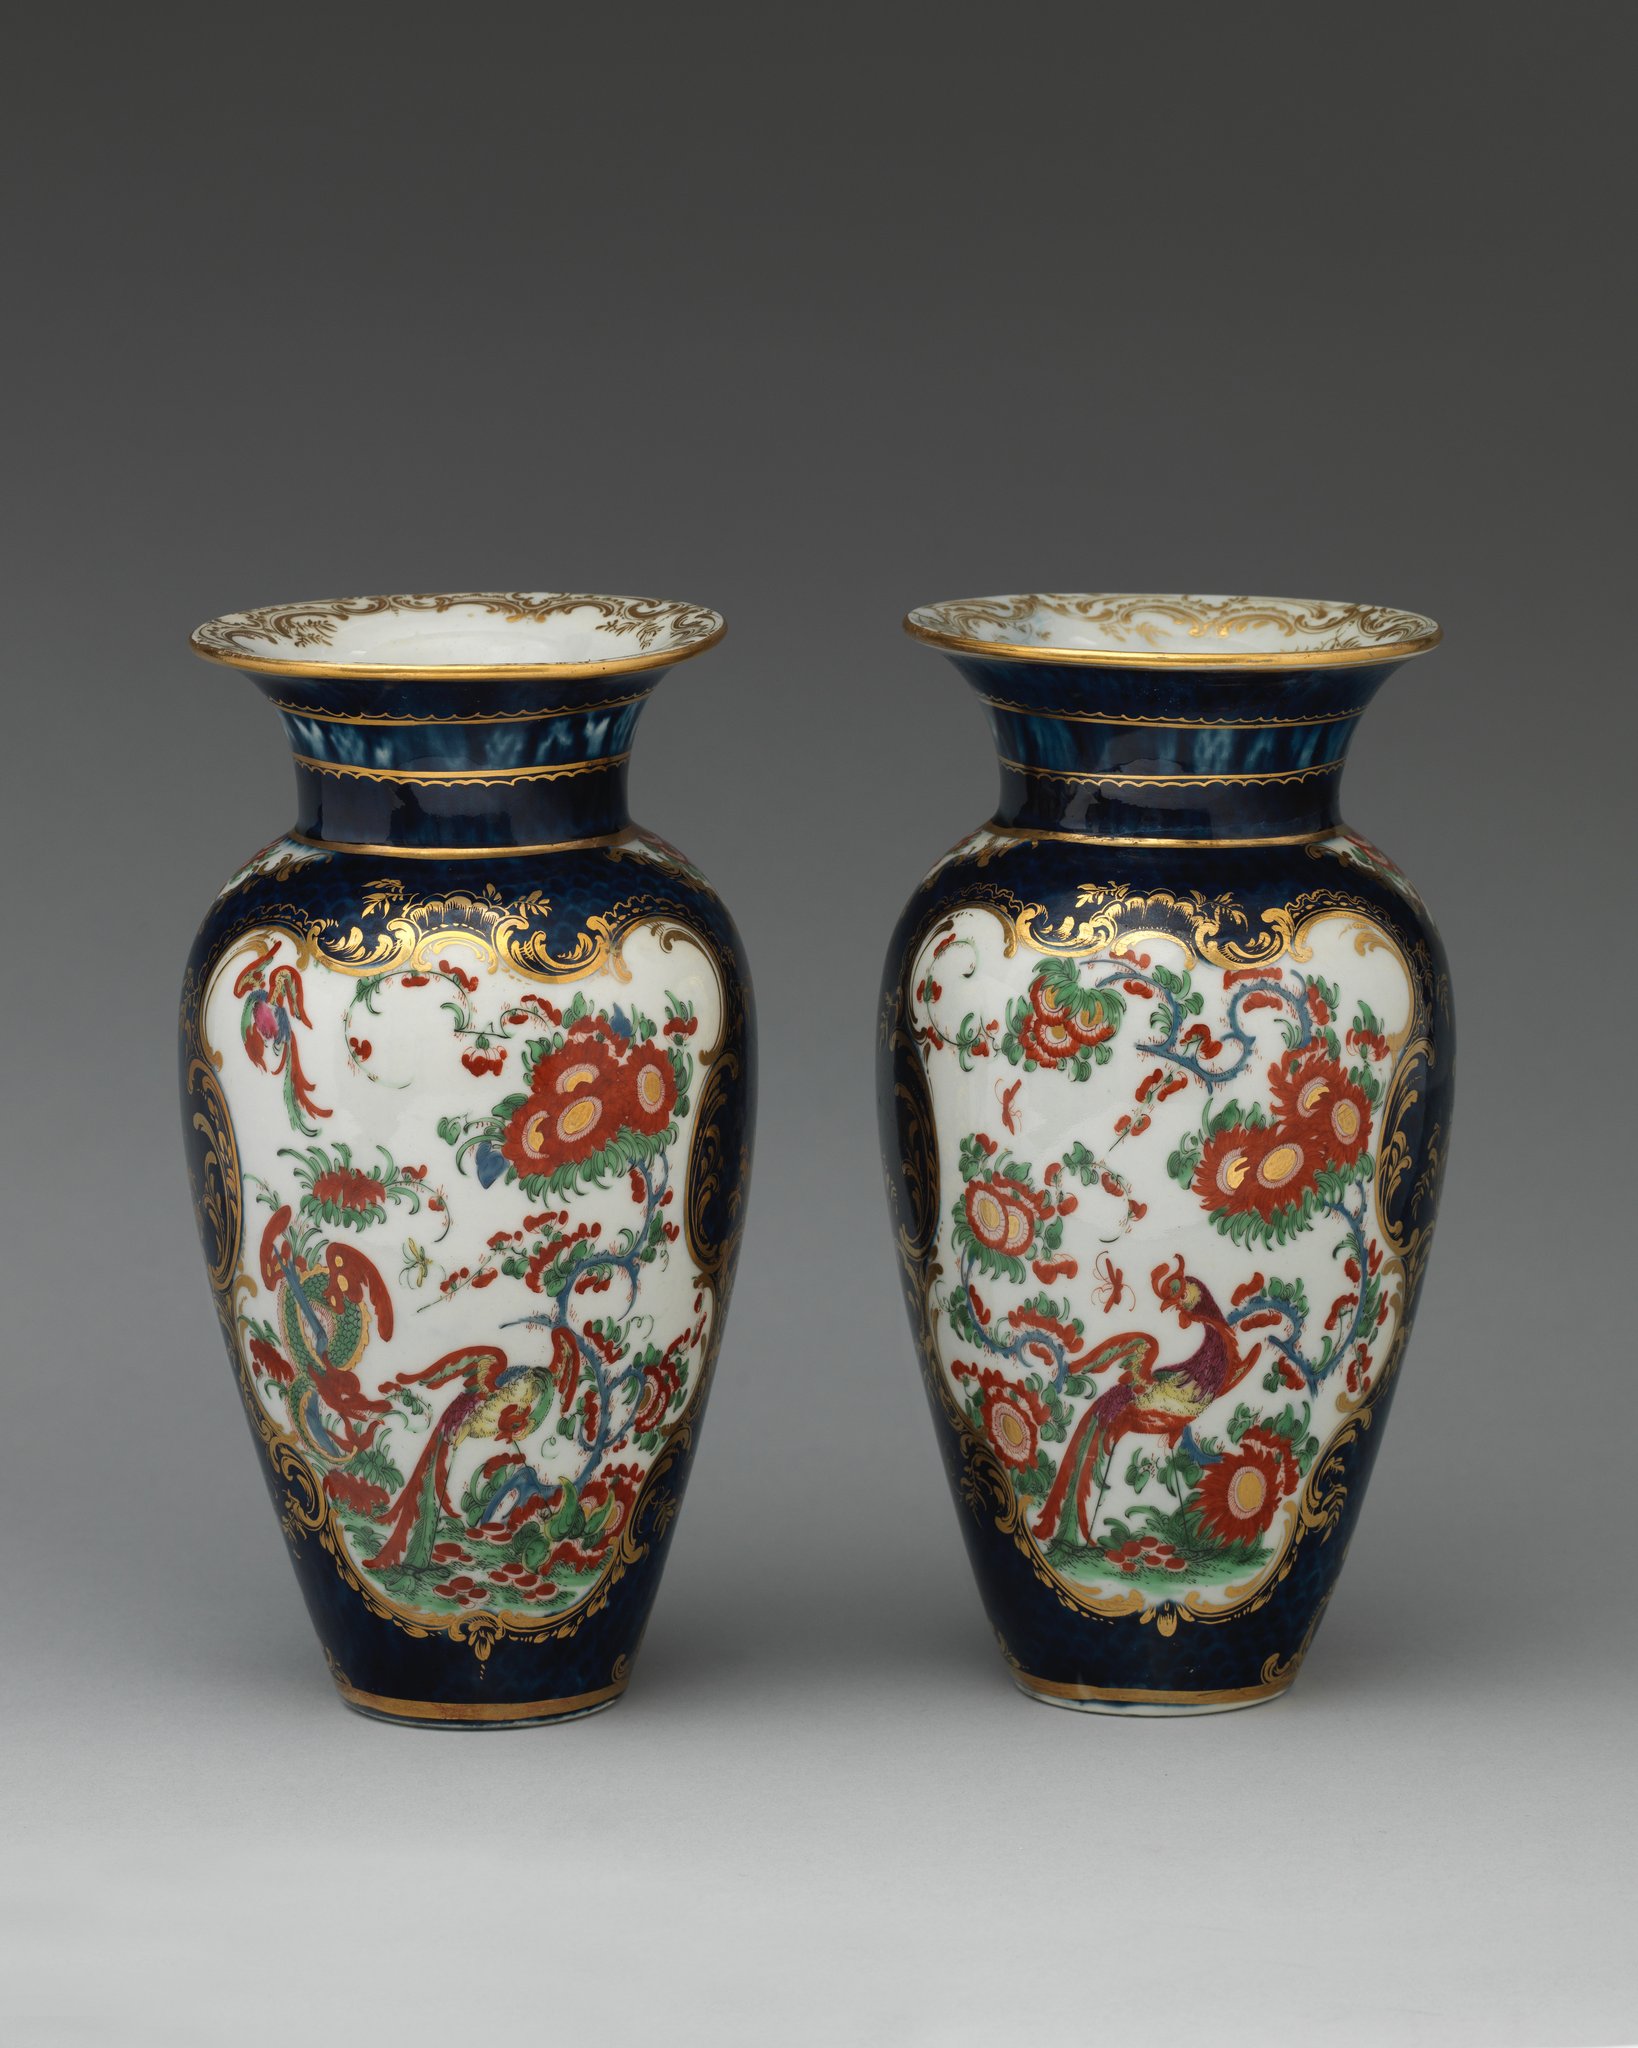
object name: vase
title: Vase (one of a pair)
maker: worcester factory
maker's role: factory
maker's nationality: british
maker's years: 1751-2008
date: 1770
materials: soft paste porcelain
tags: birds,flowers